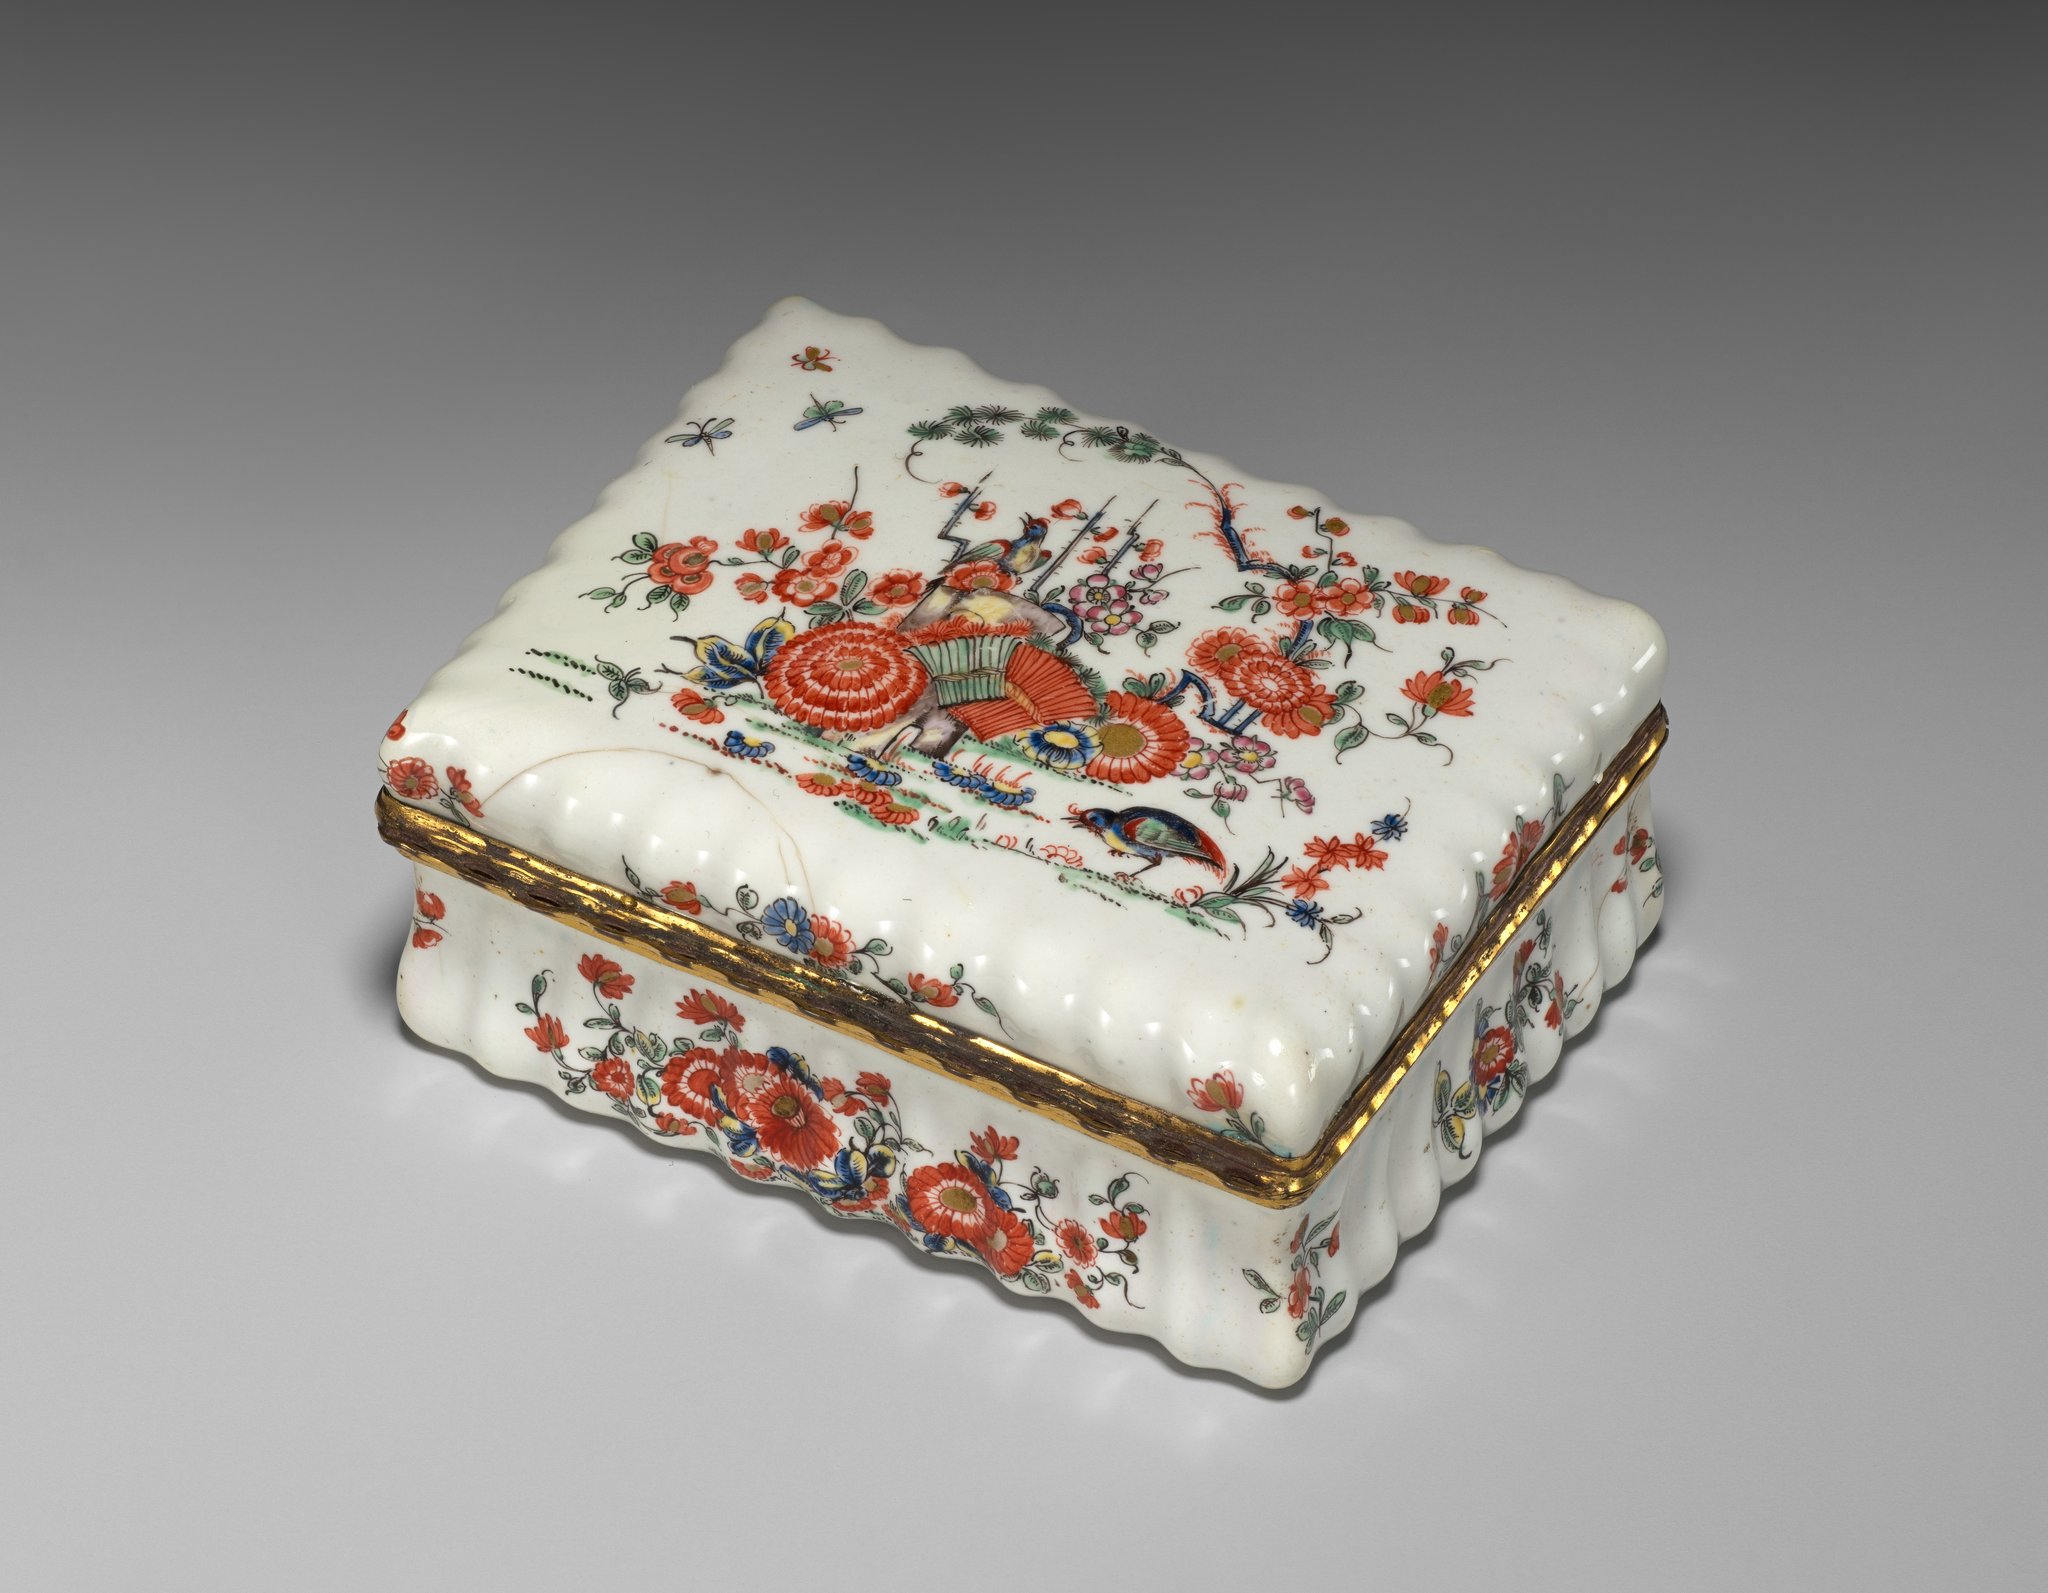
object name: snuffbox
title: Kakiemon-style snuffbox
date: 1750-1759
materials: copper, enamel